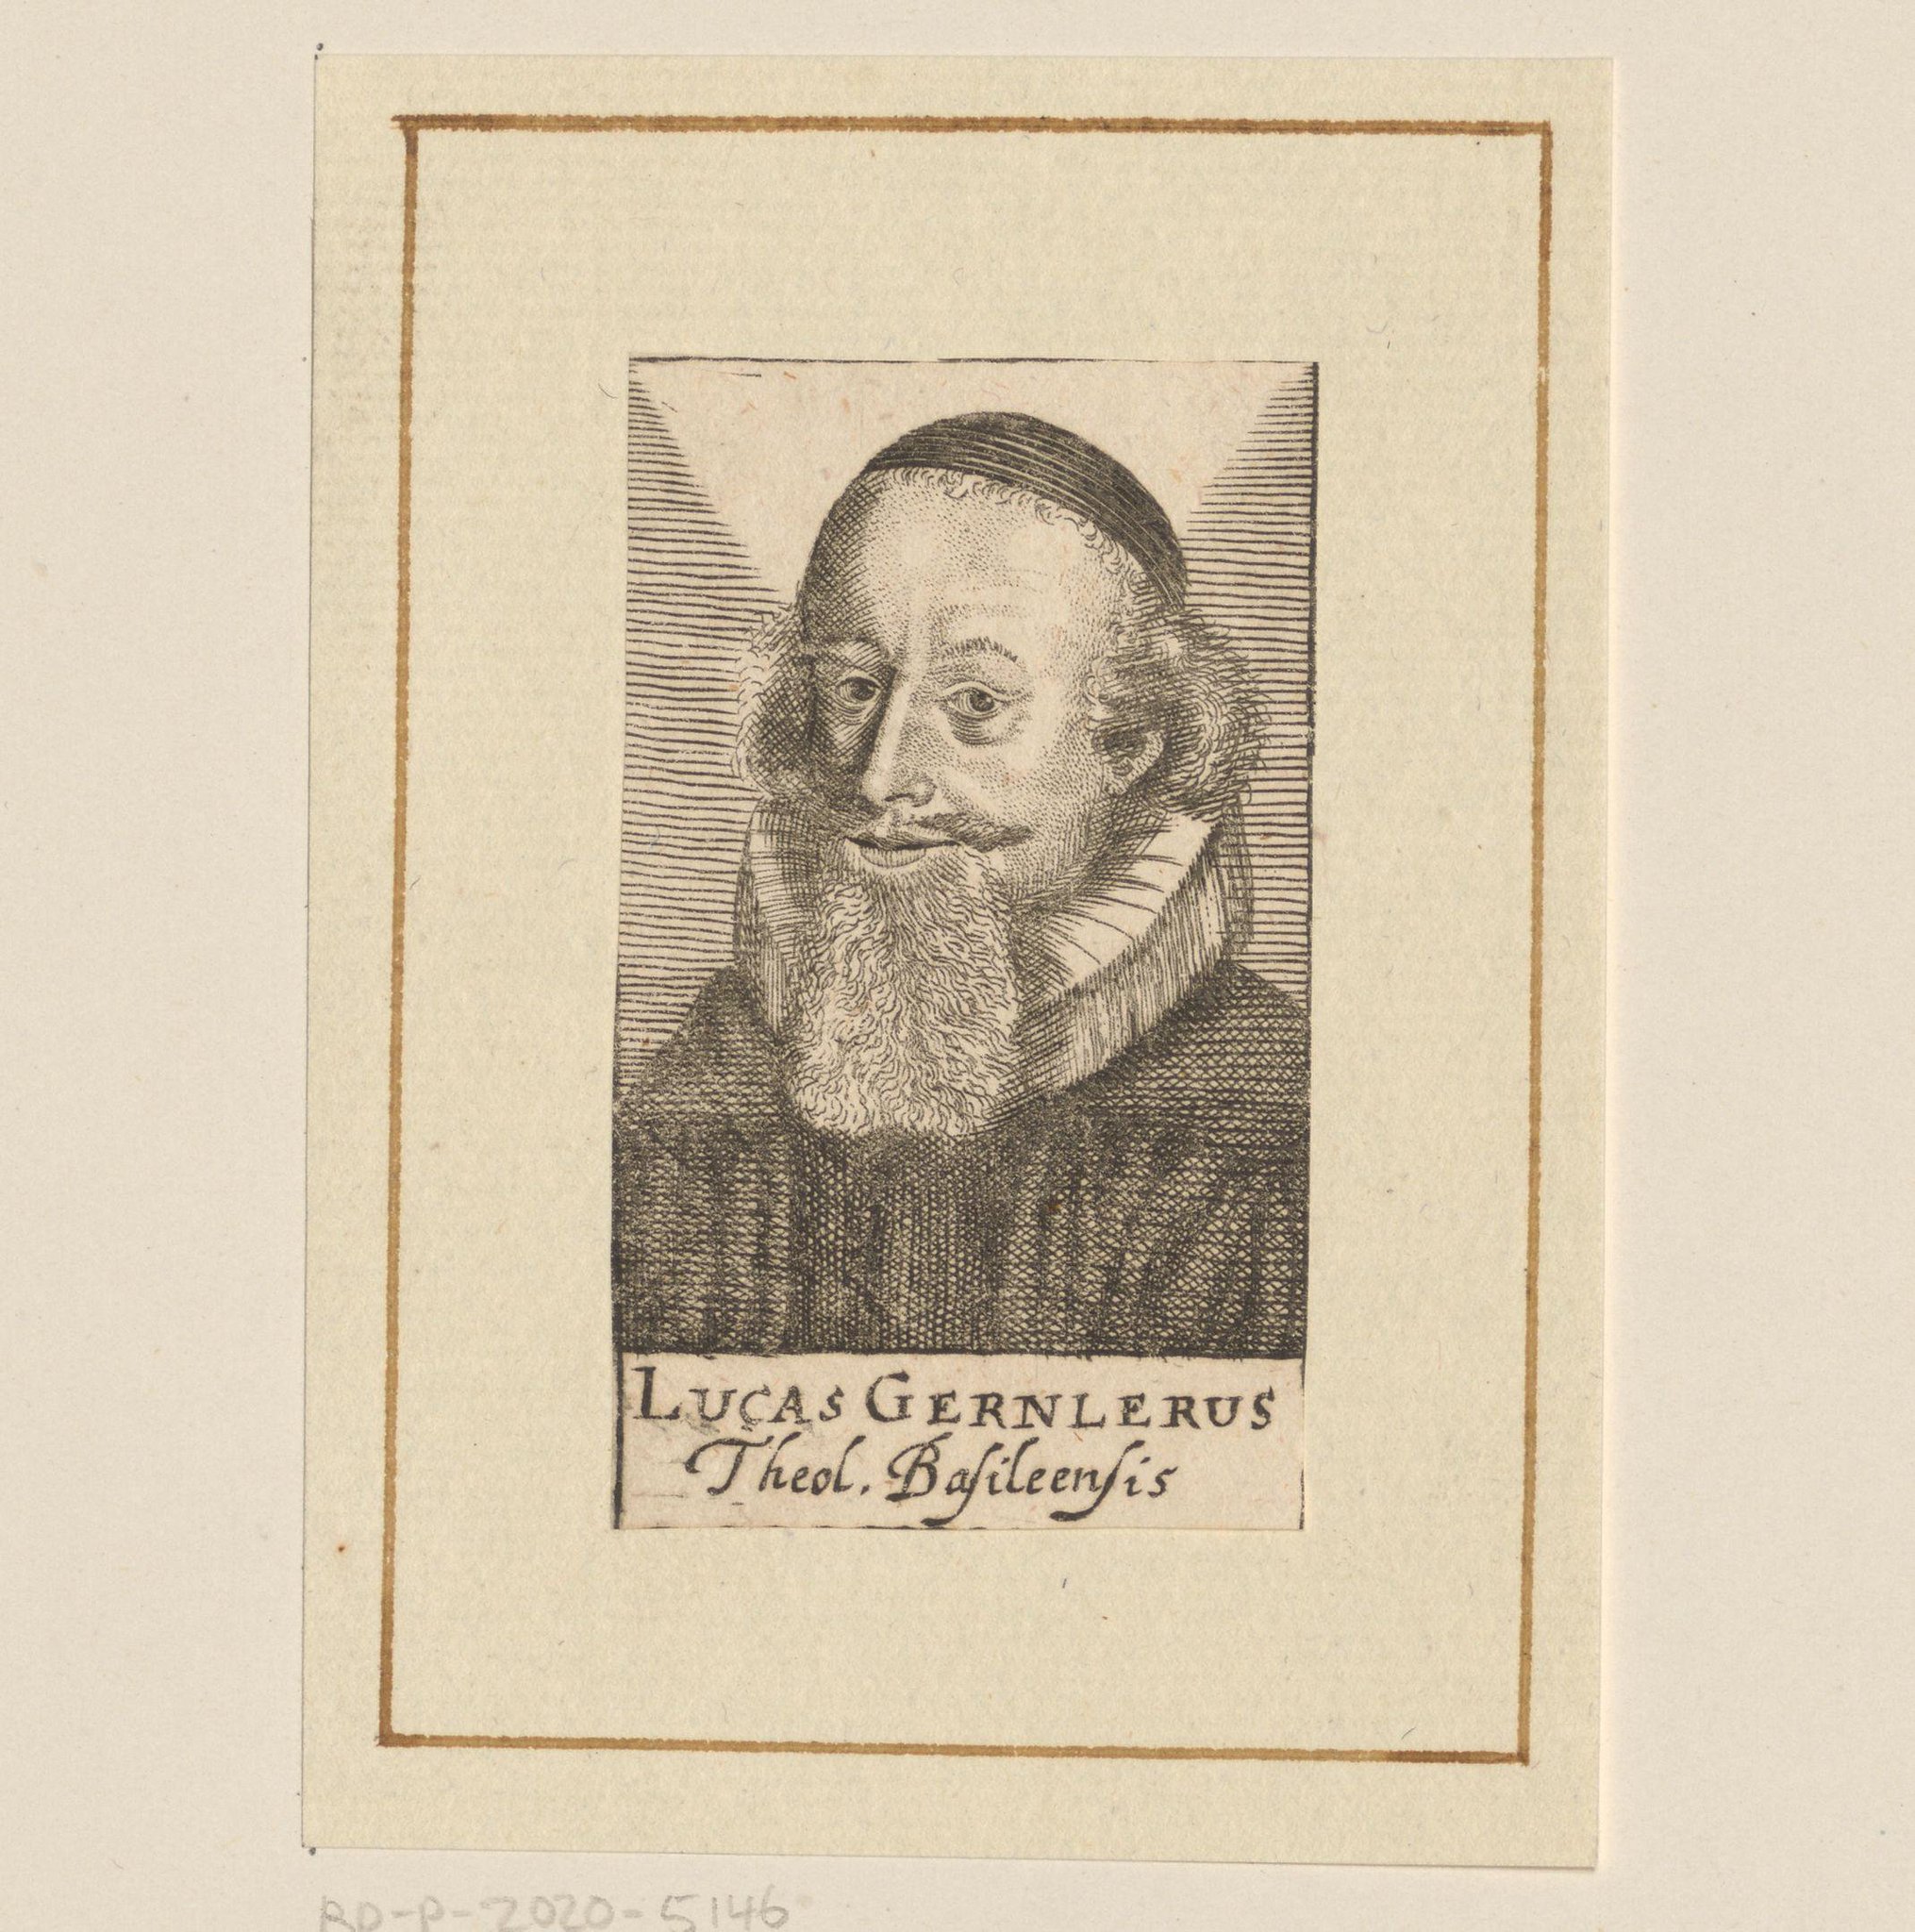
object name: print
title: Portret van Lukas Gernler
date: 1688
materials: paper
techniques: engraving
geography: nuremberg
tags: theologian, historical persons, professor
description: Prent uit: Freher, Paul. Theatrum virorum eruditione clarorum. Neurenberg: Johann Hoffmann, 1688, blad 31.